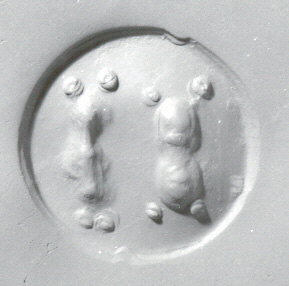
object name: stamp seal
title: Drilled oval hemispheroid seal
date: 3500-2900 BCE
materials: marble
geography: iran or mesopotamia